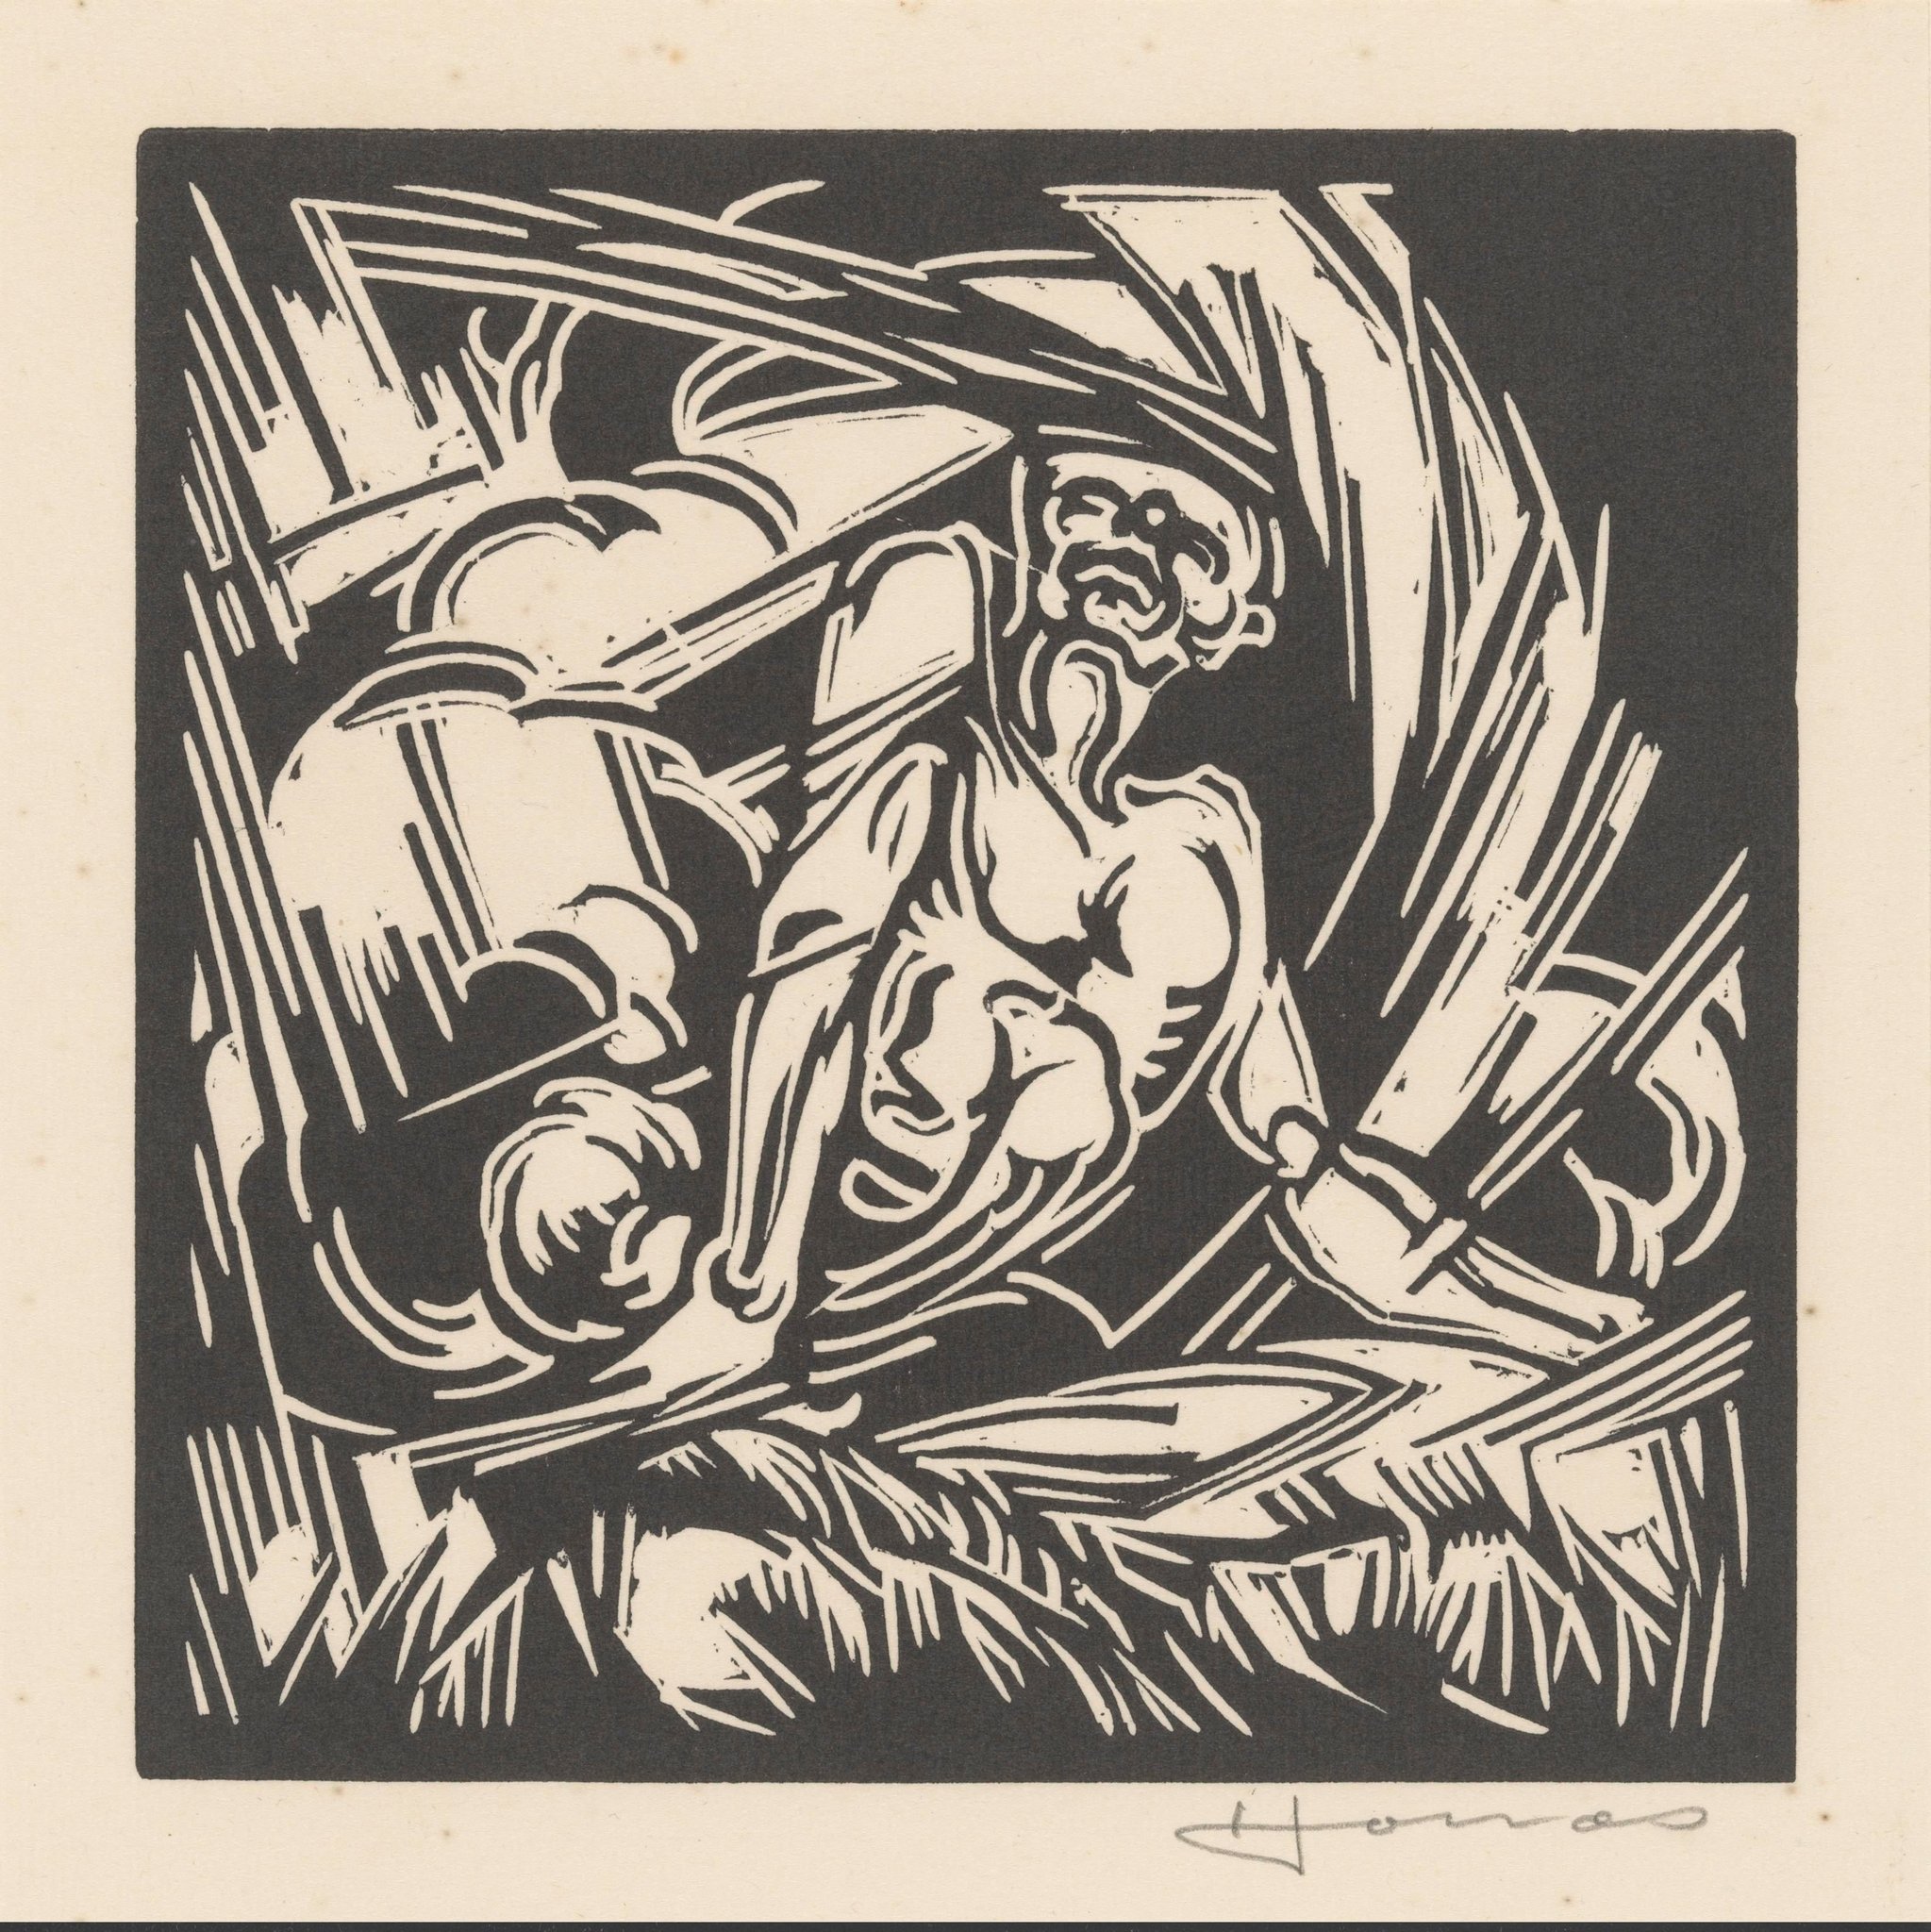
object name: print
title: Personificatie van de wind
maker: henri jonas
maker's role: draughtsman, print maker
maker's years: 1878-1944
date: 1921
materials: paper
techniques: woodcut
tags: winds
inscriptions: collector's mark: Lugt 2228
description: Prent gebruikt voor: Kemp, Mathias. De zeven broeders. Maastricht: Leiter-Nypels, 1921.